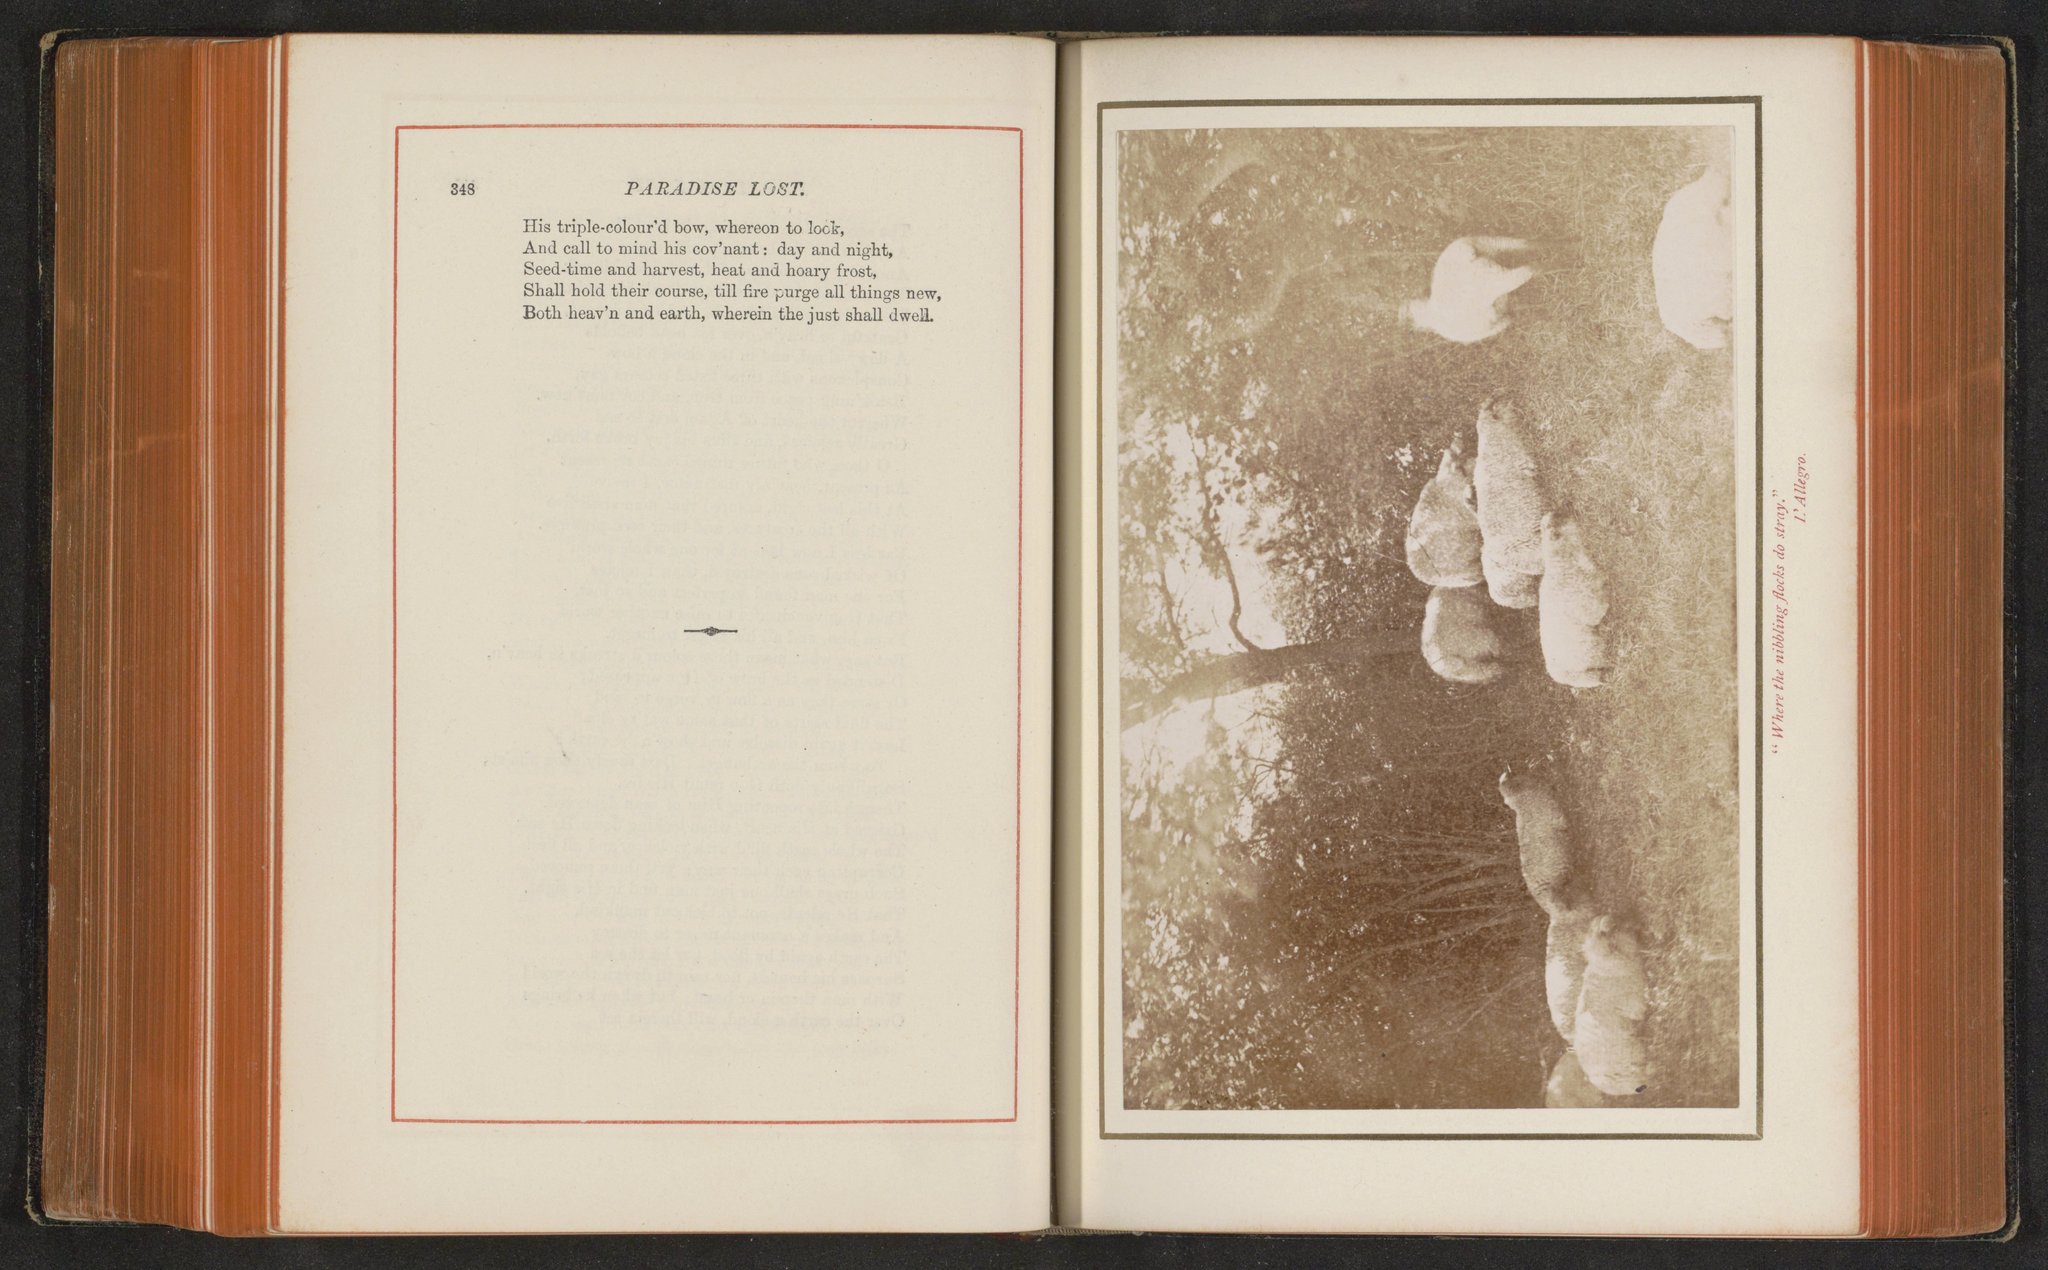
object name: page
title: Kudde schapen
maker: deswall vaughan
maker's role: fotograaf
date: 1875-1885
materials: photographic support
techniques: albumen print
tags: sheep, herd, flock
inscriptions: inscription: ‘" Where the nibbling flocks do stray." L'Allegro.’